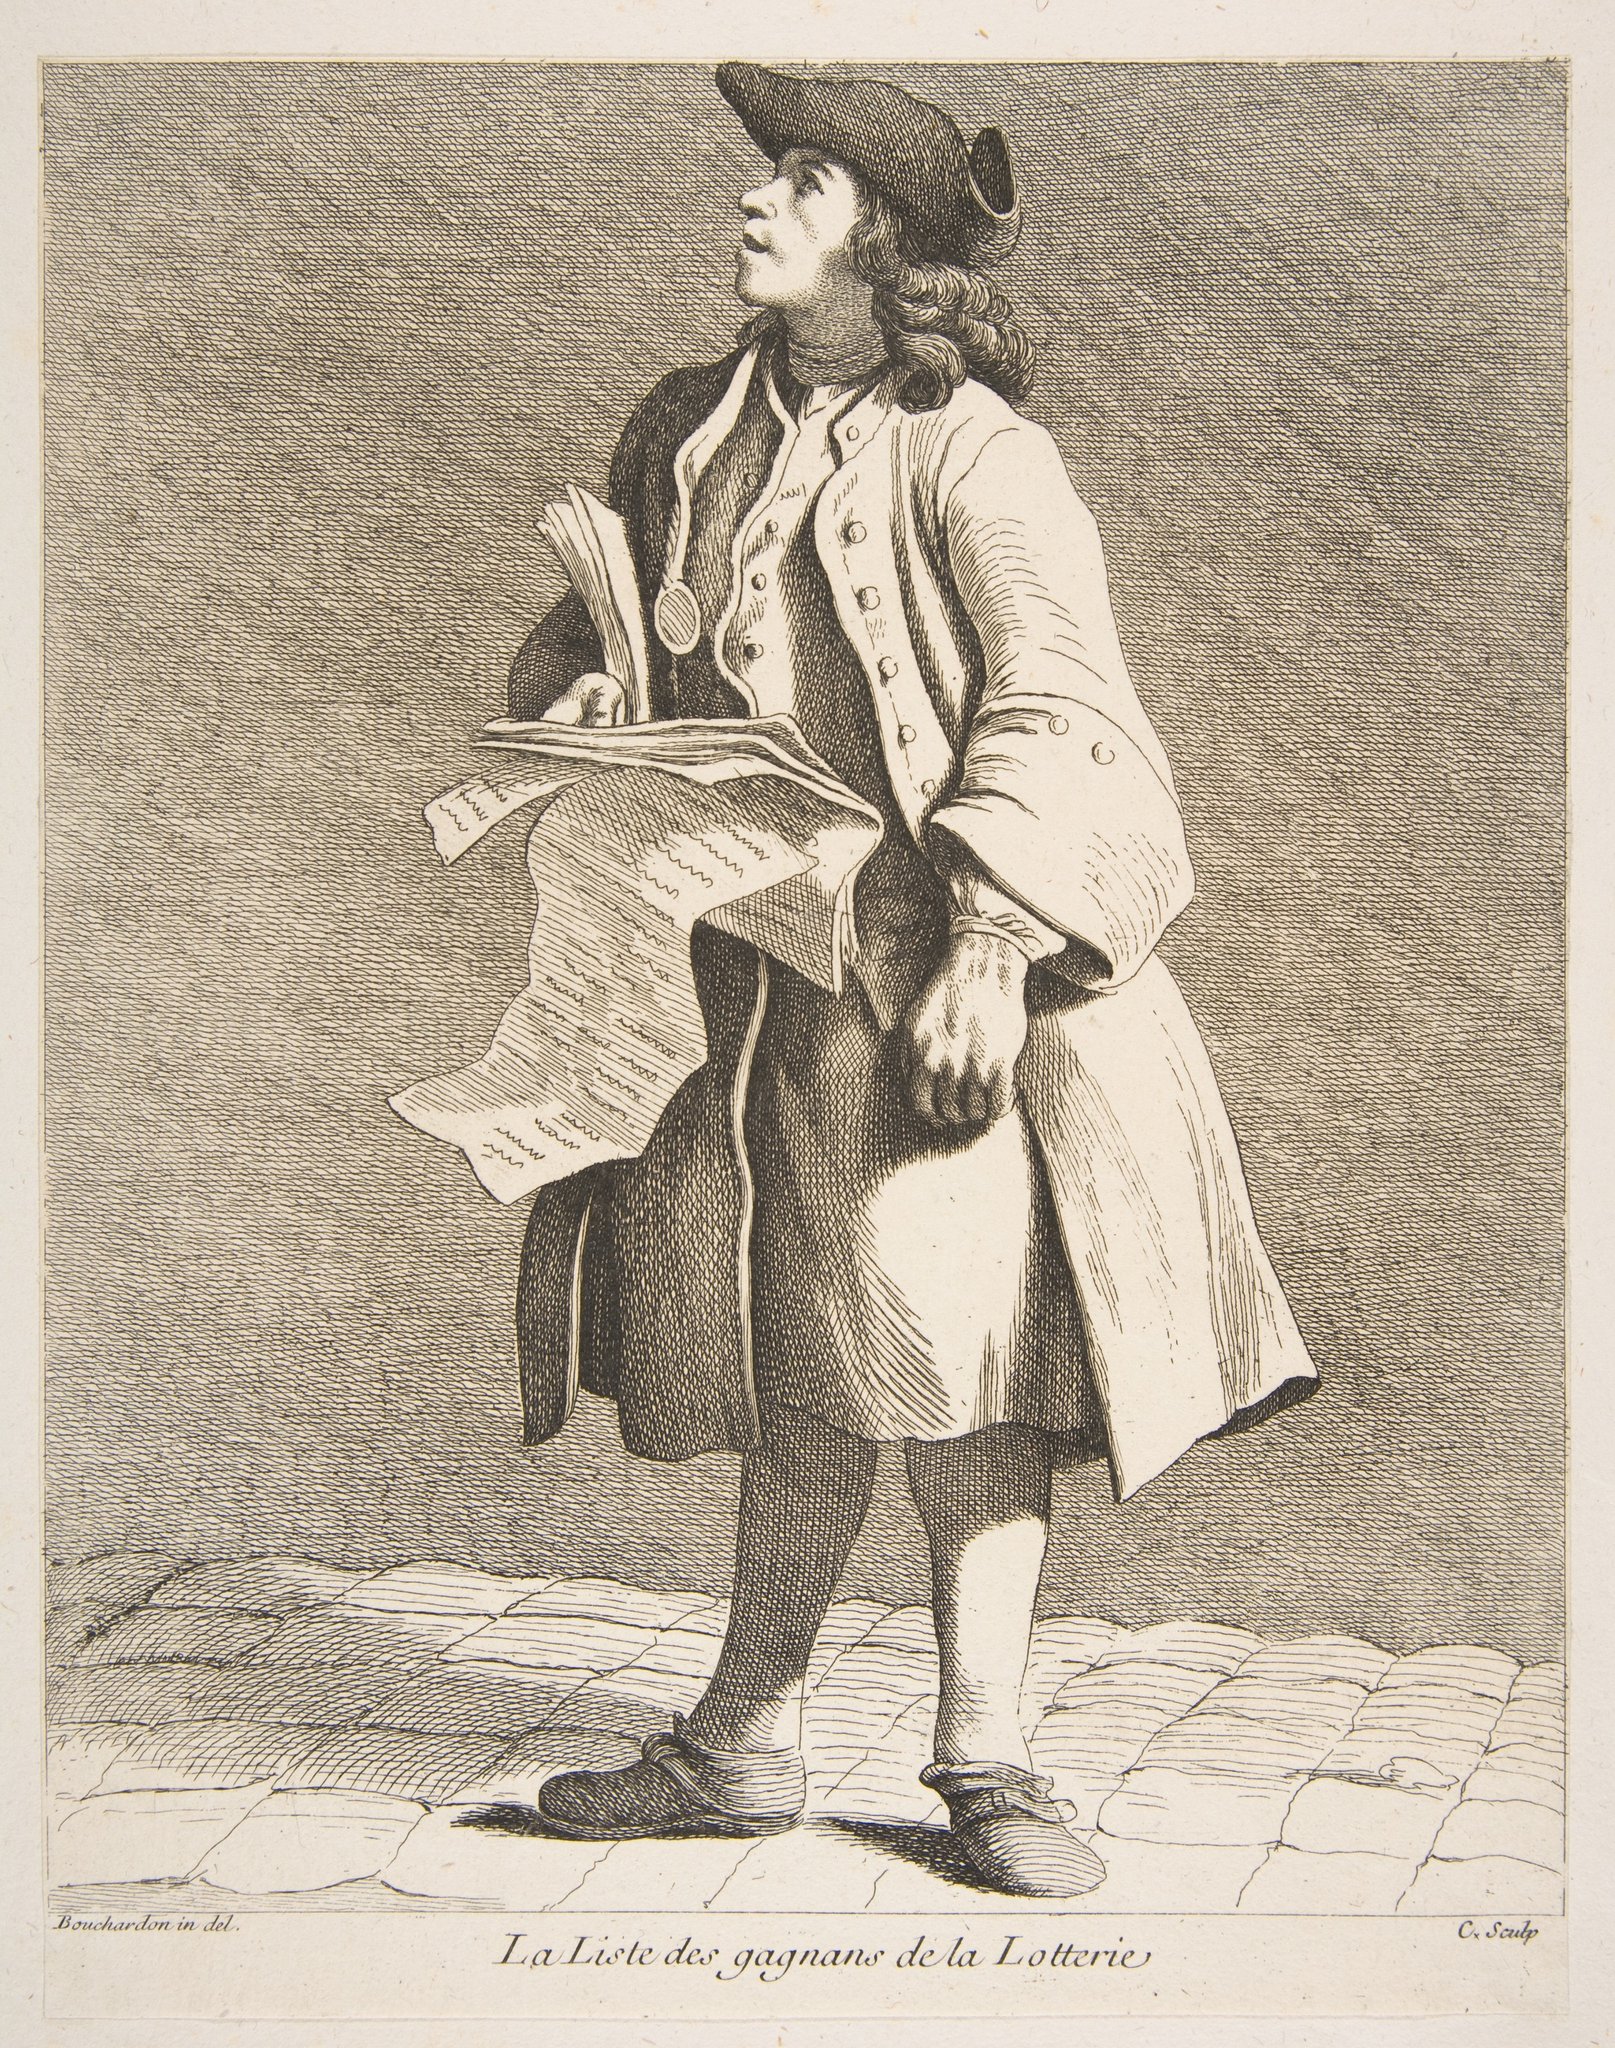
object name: print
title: The Reading of Lottery Winners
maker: anne claude philippe de tubières, comte de caylus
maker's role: artist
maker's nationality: french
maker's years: 1692-1765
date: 1746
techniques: engraving, etching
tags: men